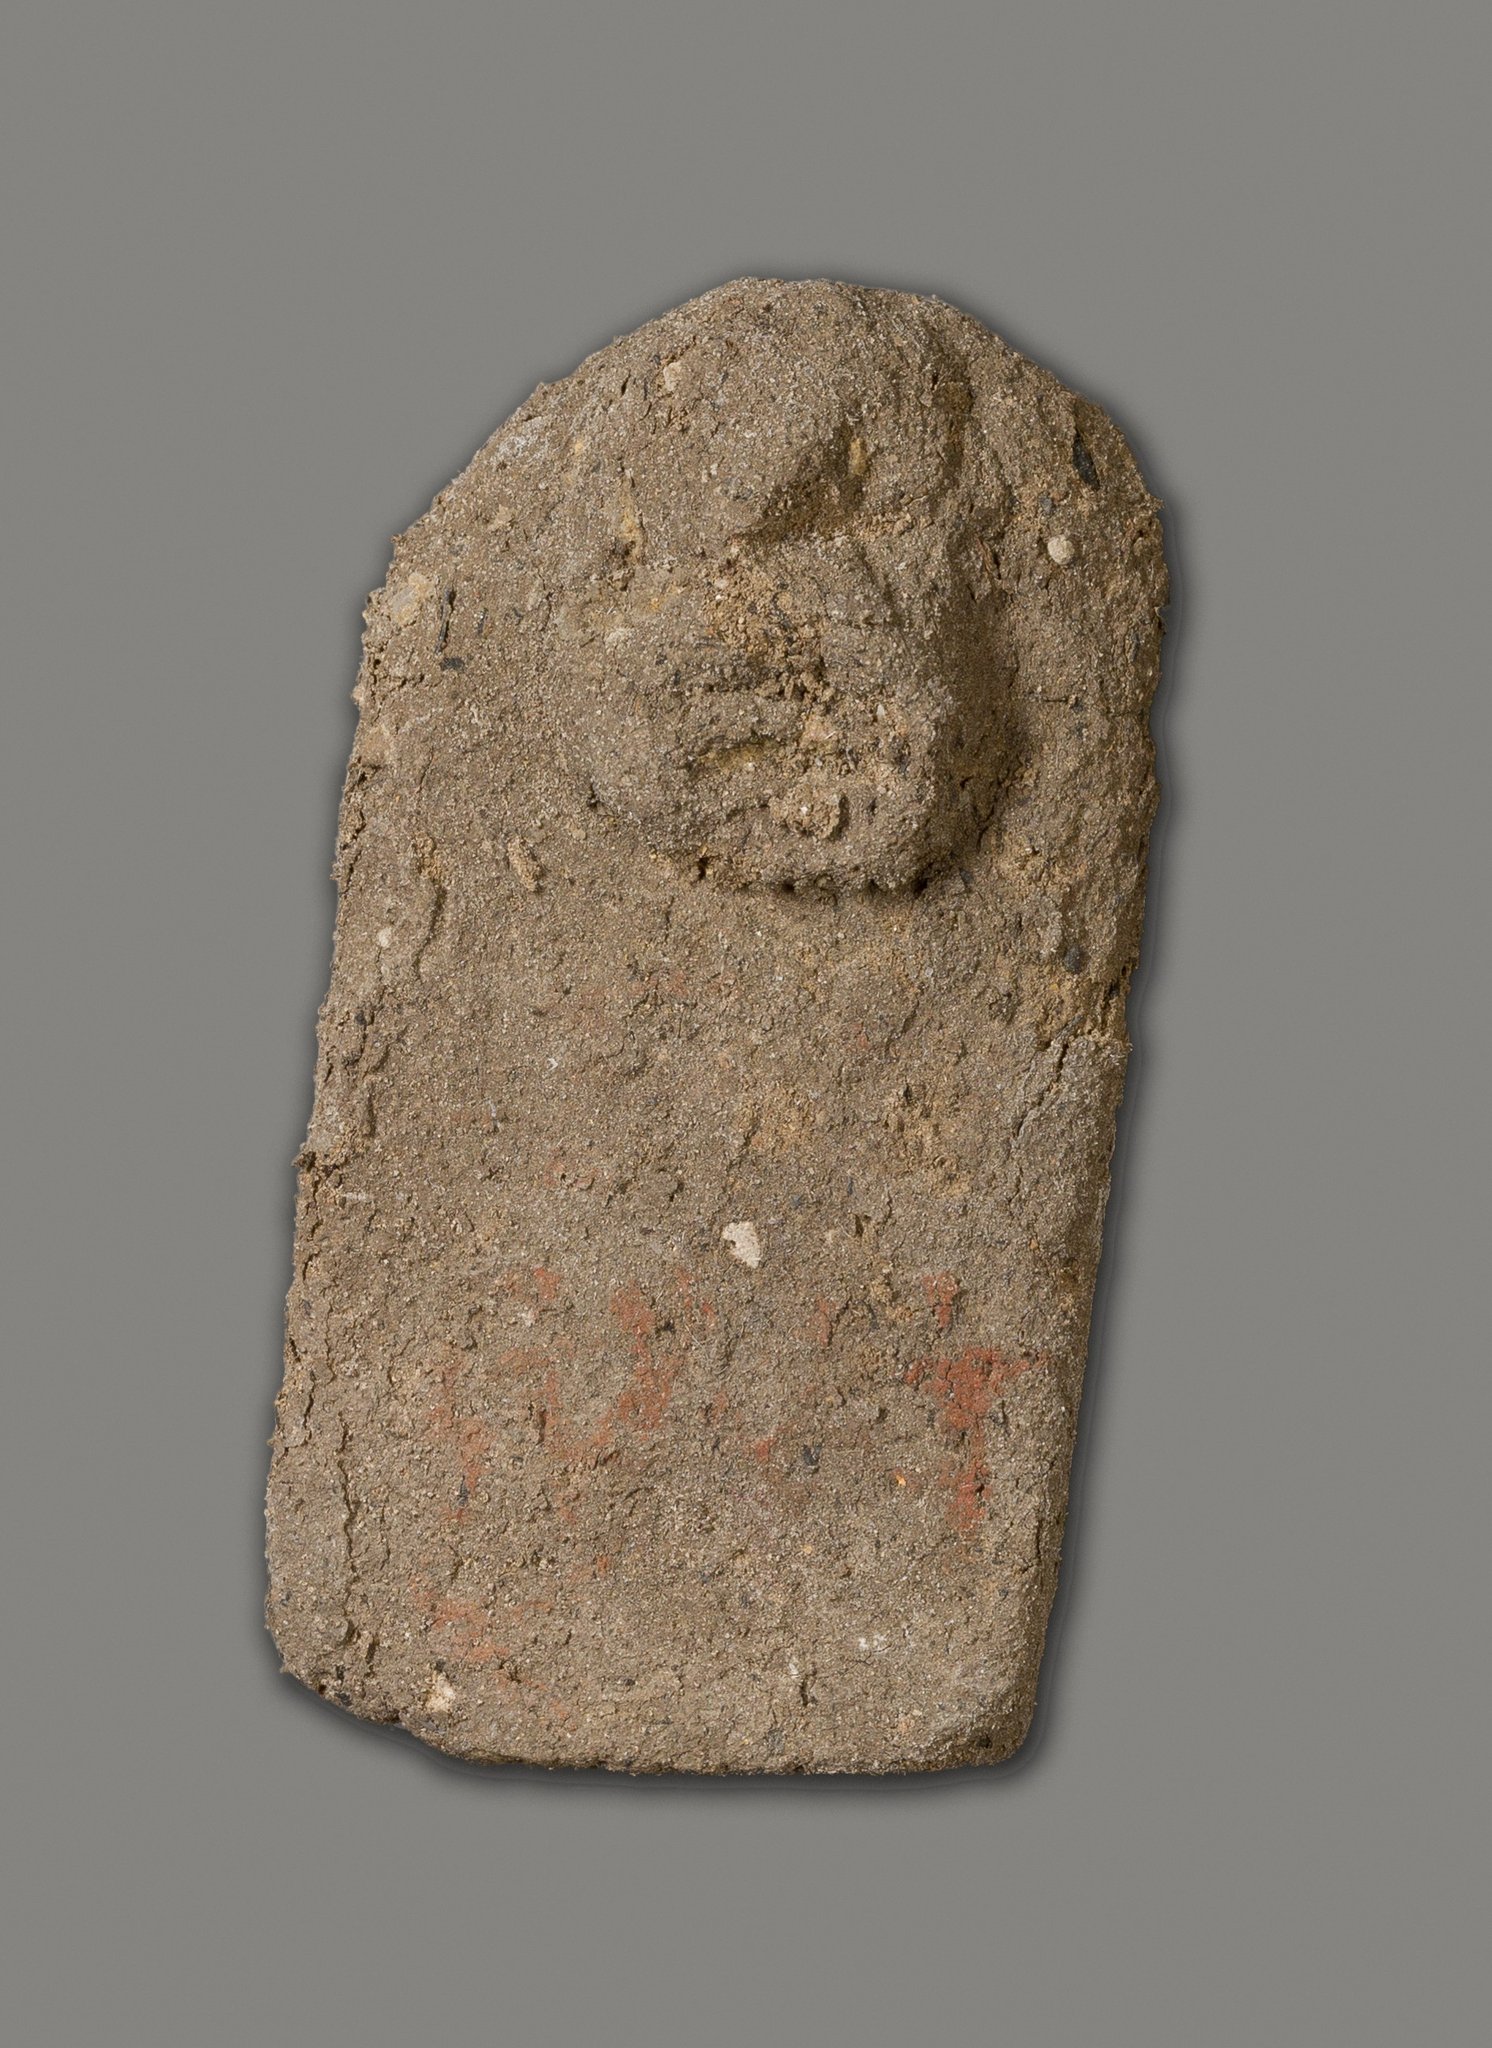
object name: figure, magical, execration, tablet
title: Magical Figure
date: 1802-1550 BCE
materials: clay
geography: egypt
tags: faces